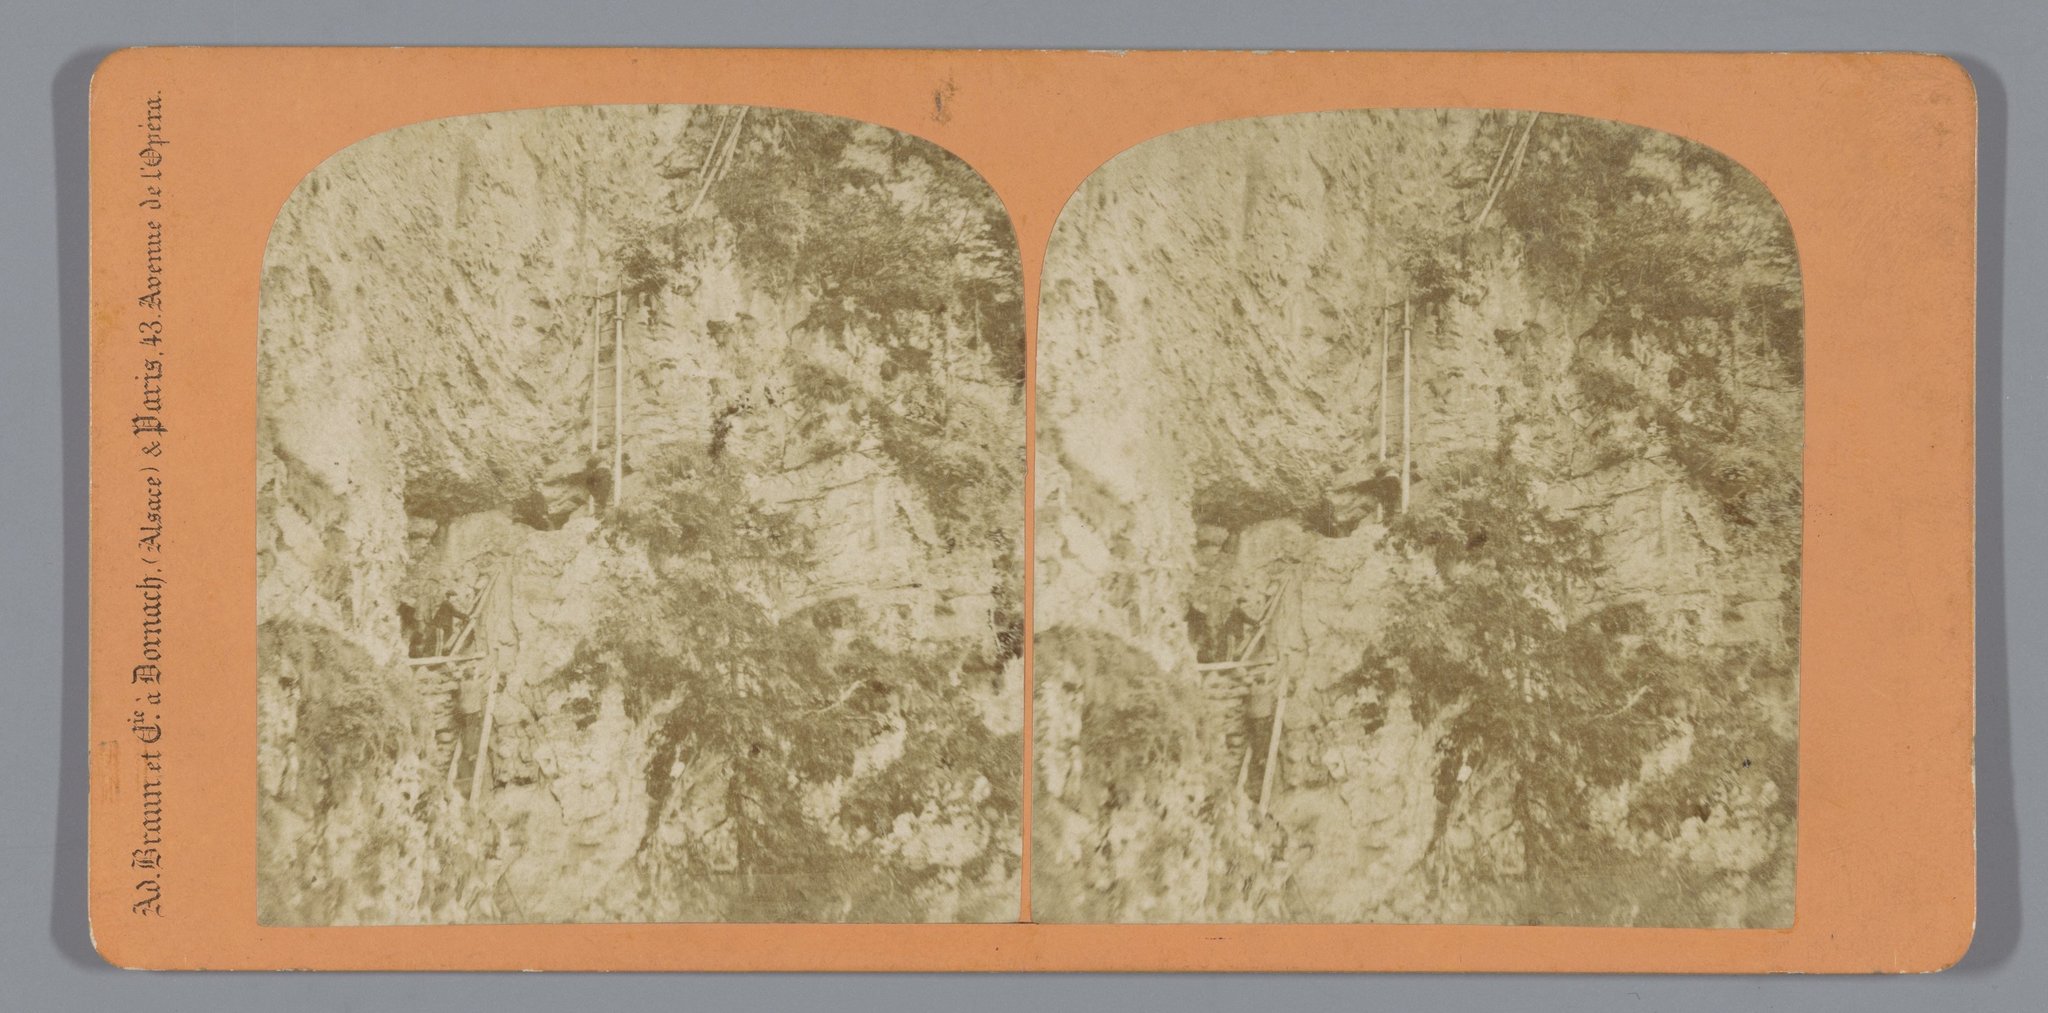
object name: stereograph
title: Passage des echelles a Loueche. (Valais)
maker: Anonymous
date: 1881-1900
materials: cardboard, paper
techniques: albumen print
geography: dornach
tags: mountain climbing, mountaineering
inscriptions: number: ‘No 6464.’, inscription: ‘à Dornach. (Alsace) & Paris,43. Avenue de l'Opéra.’